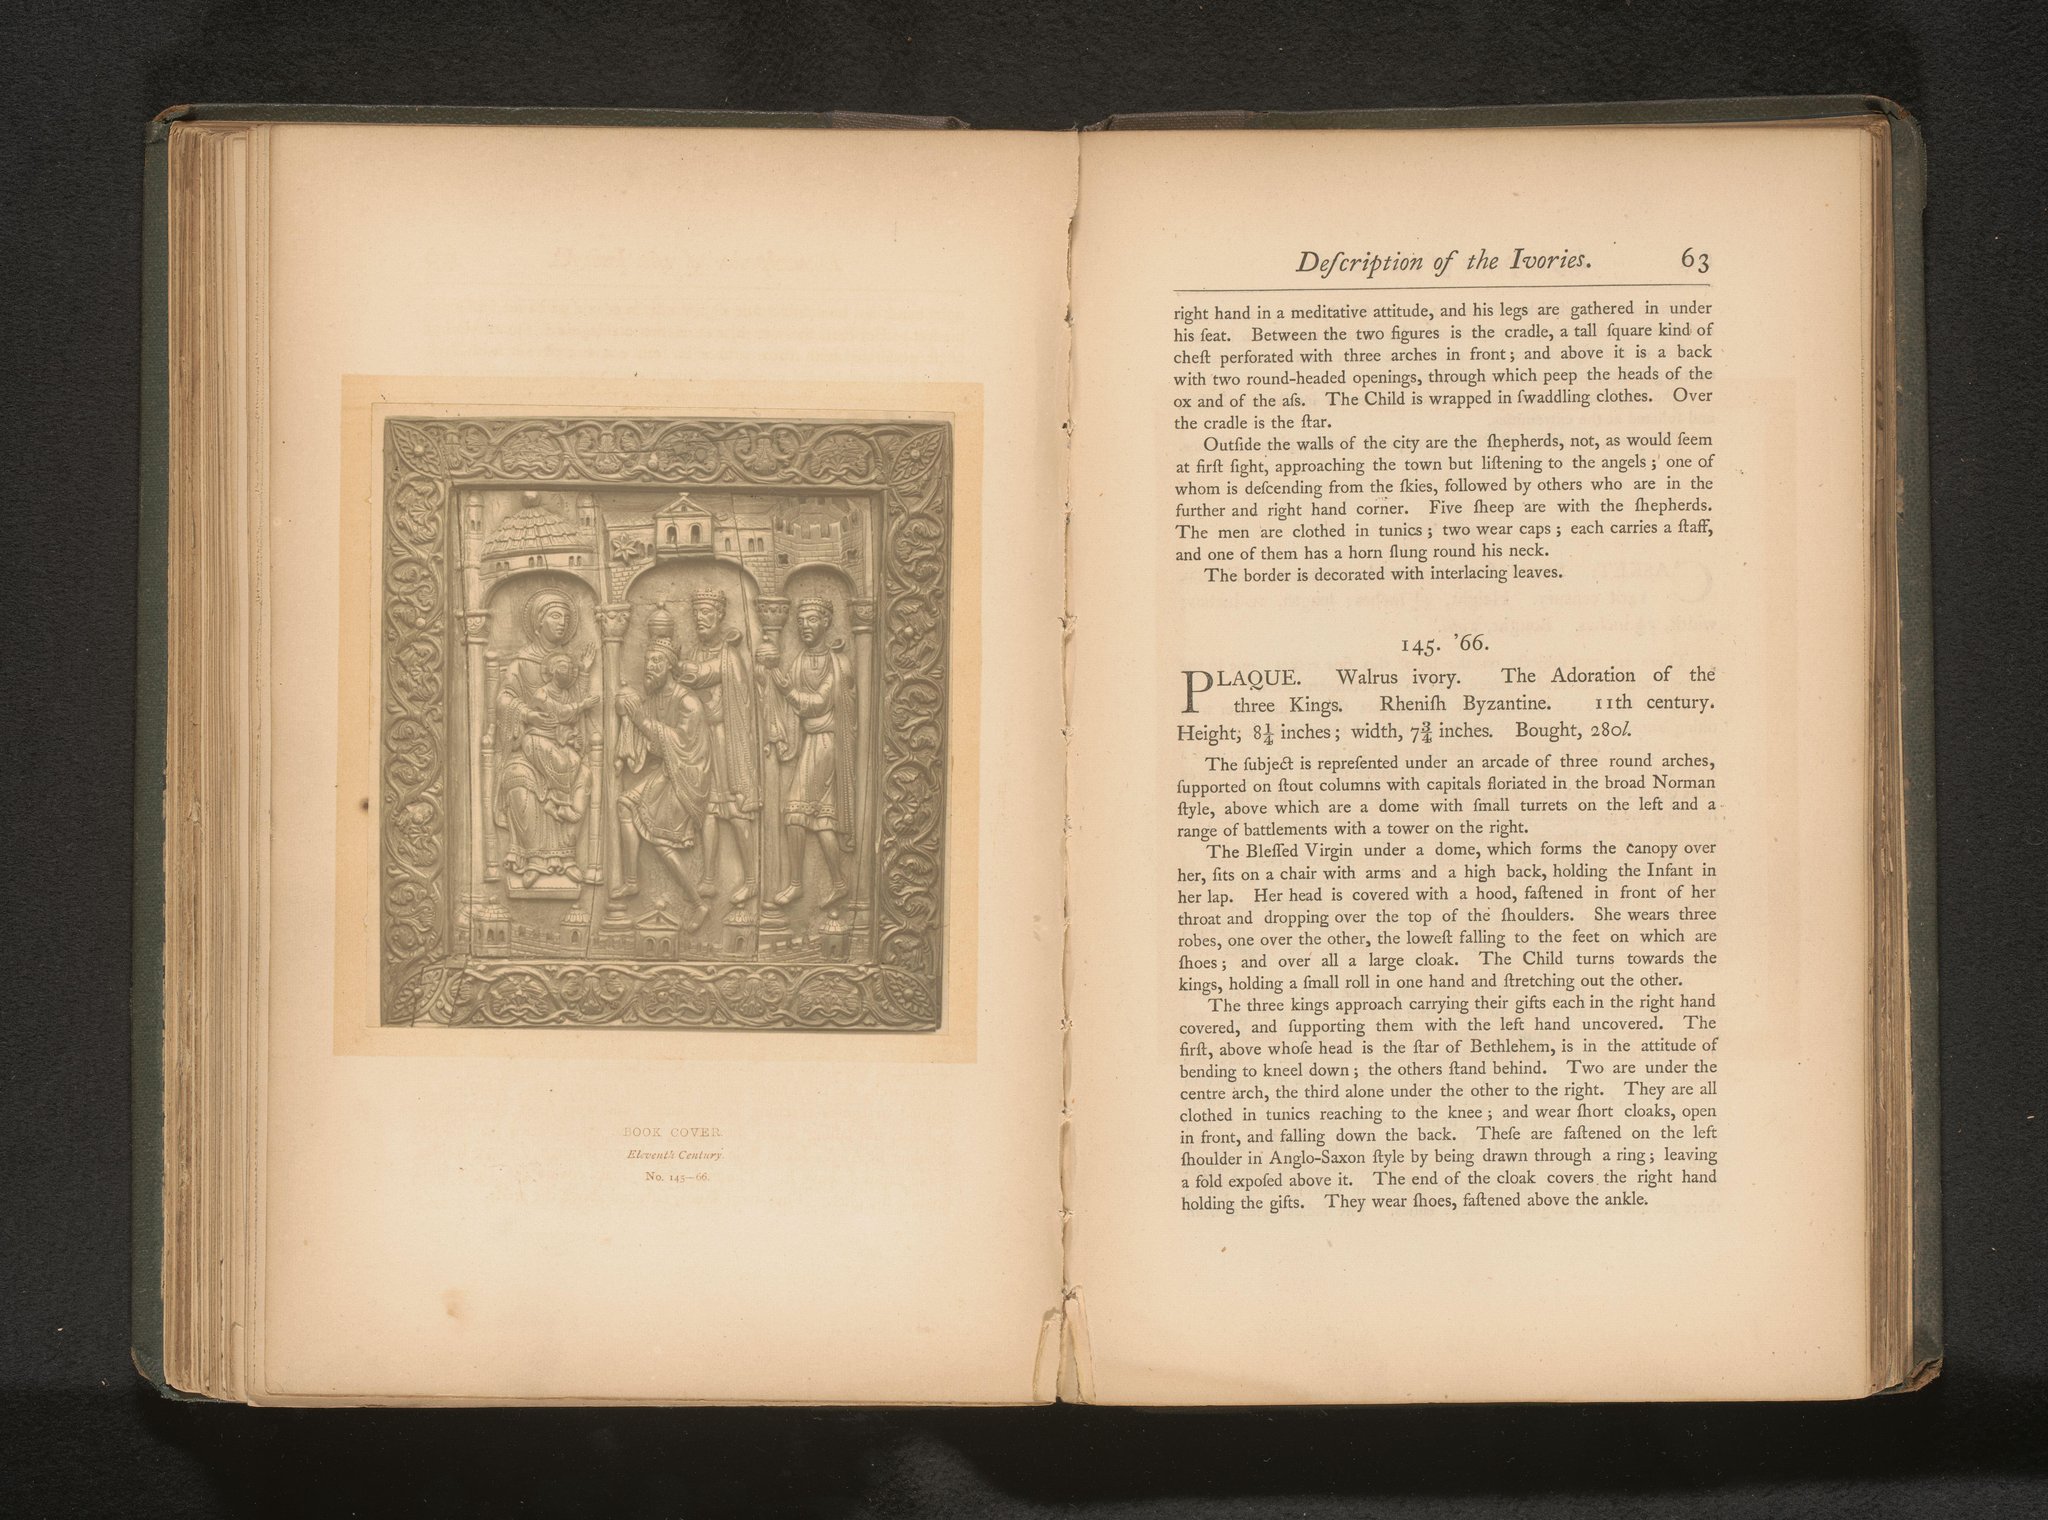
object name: page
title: Book cover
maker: Anonymous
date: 1867-1872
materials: paper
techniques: woodburytype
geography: london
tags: adoration of the kings: the wise men present their gifts to the christ-child (gold, frankincense and myrrh), book-cover, binding, sculpture (+ relief ~ sculpture)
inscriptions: number: ‘No. 145-66.’, inscription: ‘Eleventh Century.’